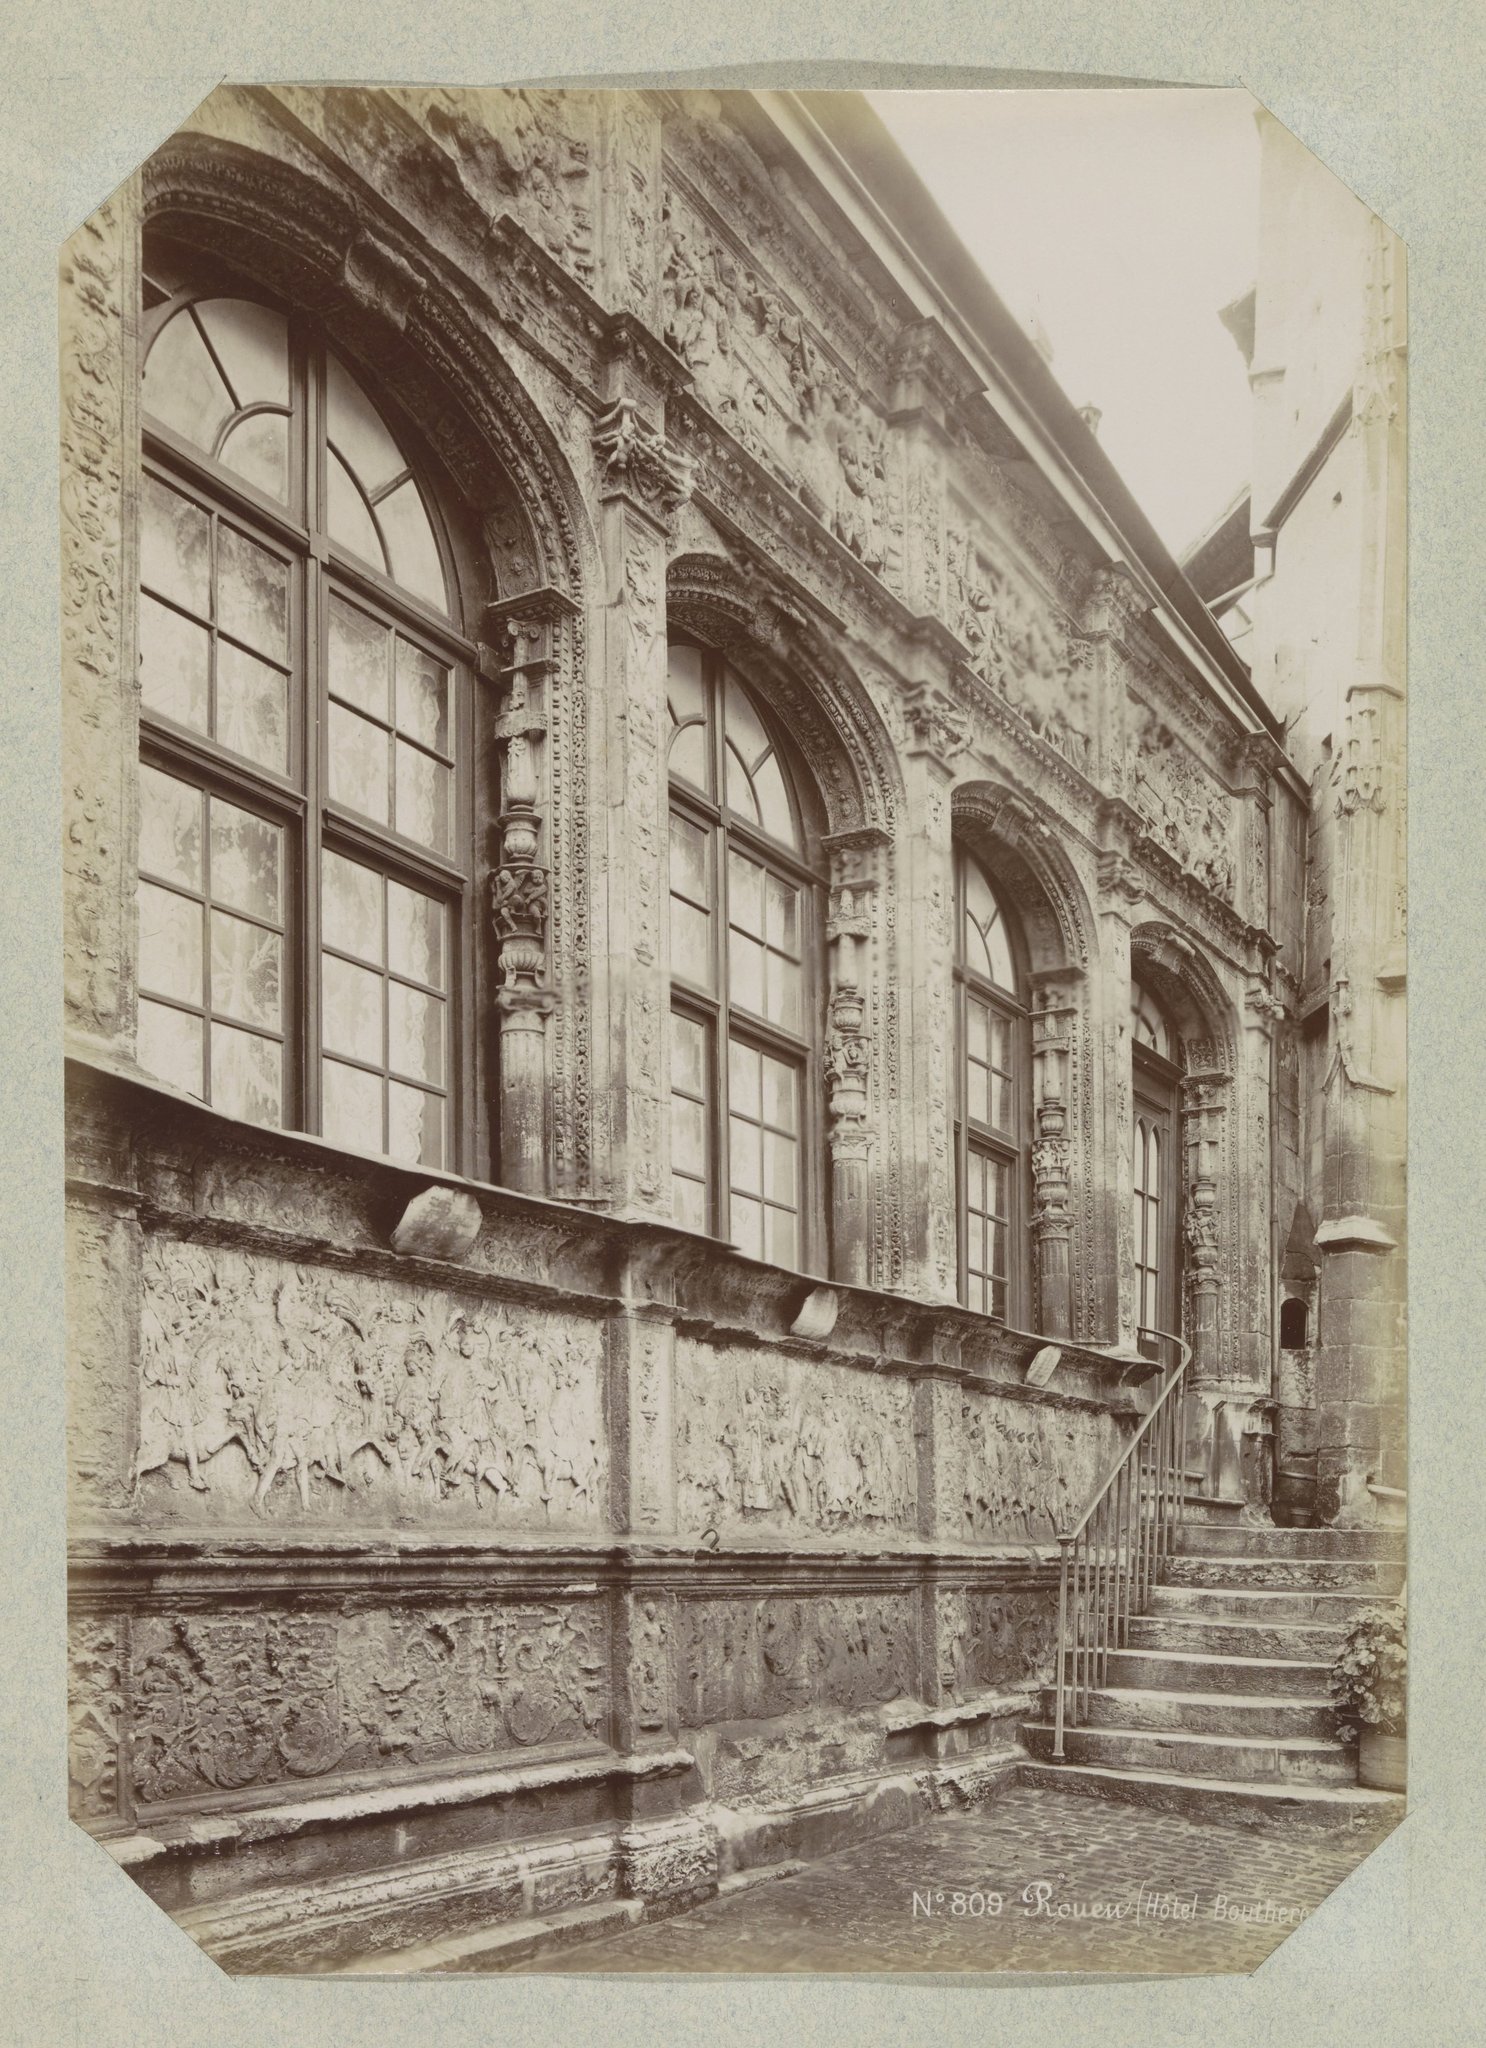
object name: photograph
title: Rouen (Hôtel Bouthero[(...)]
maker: séraphin-médéric mieusement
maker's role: fotograaf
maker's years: 1840-1905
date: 1880-1900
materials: photographic support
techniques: albumen print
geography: rouen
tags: hôtel, i.e. small palace in city, façade (of house or building)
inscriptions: name: ‘Mieusement photographe’, inscription: ‘Monuments Historiques’, number: ‘809’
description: Onderdeel van Fotoalbum met opnames van monumenten in Frankrijk.